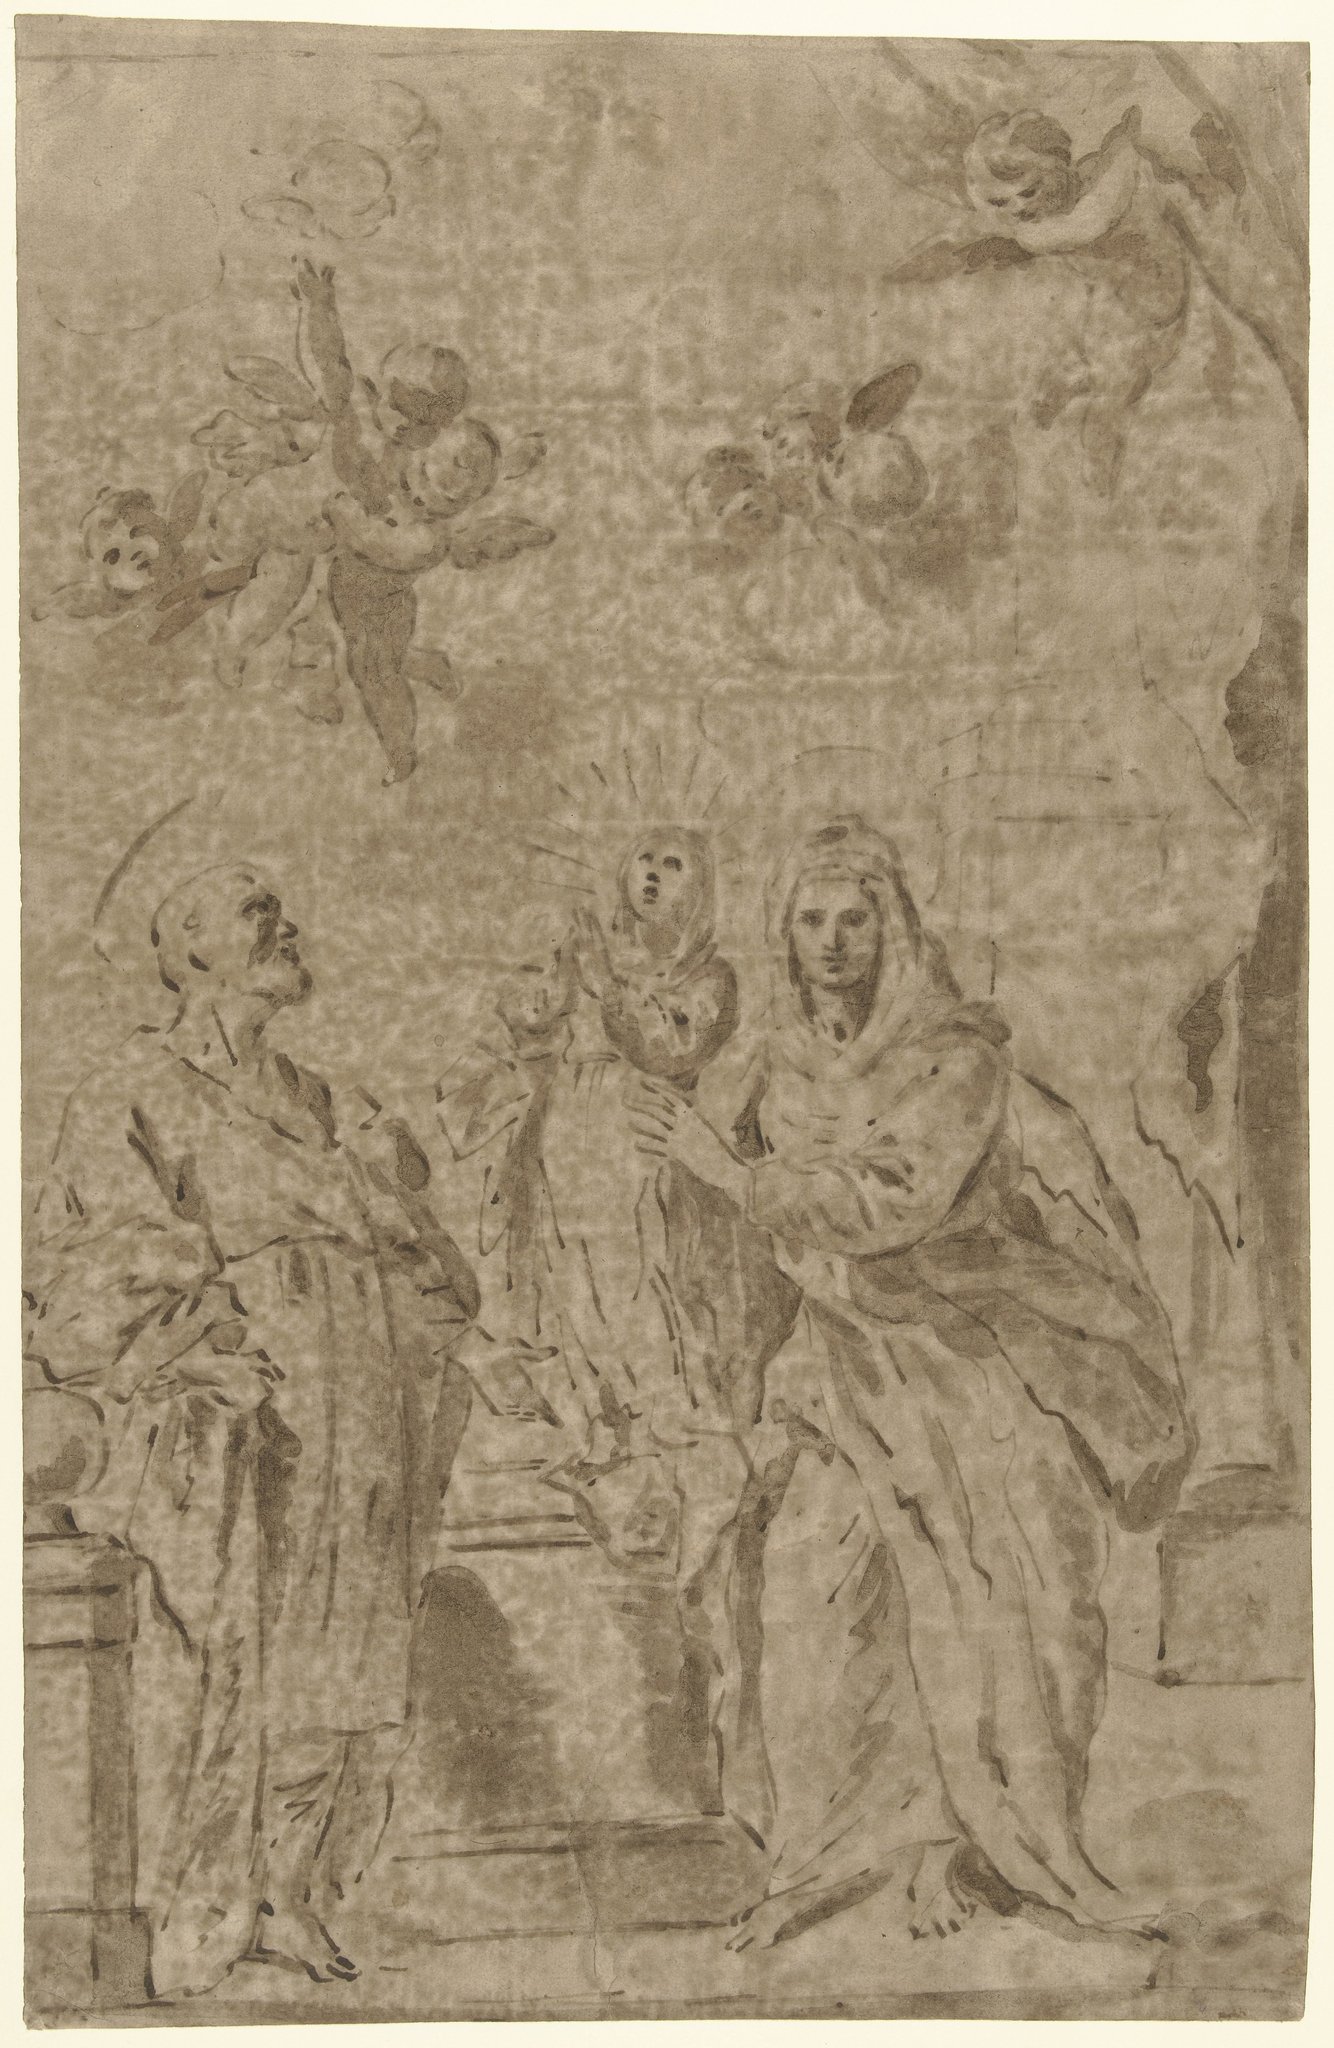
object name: drawing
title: Anna en Joachim met hun dochter Maria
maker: Anonymous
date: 1700-1800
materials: ink, paper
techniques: brush, pen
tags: devout mary together with her parents; angels, and perhaps god the father present